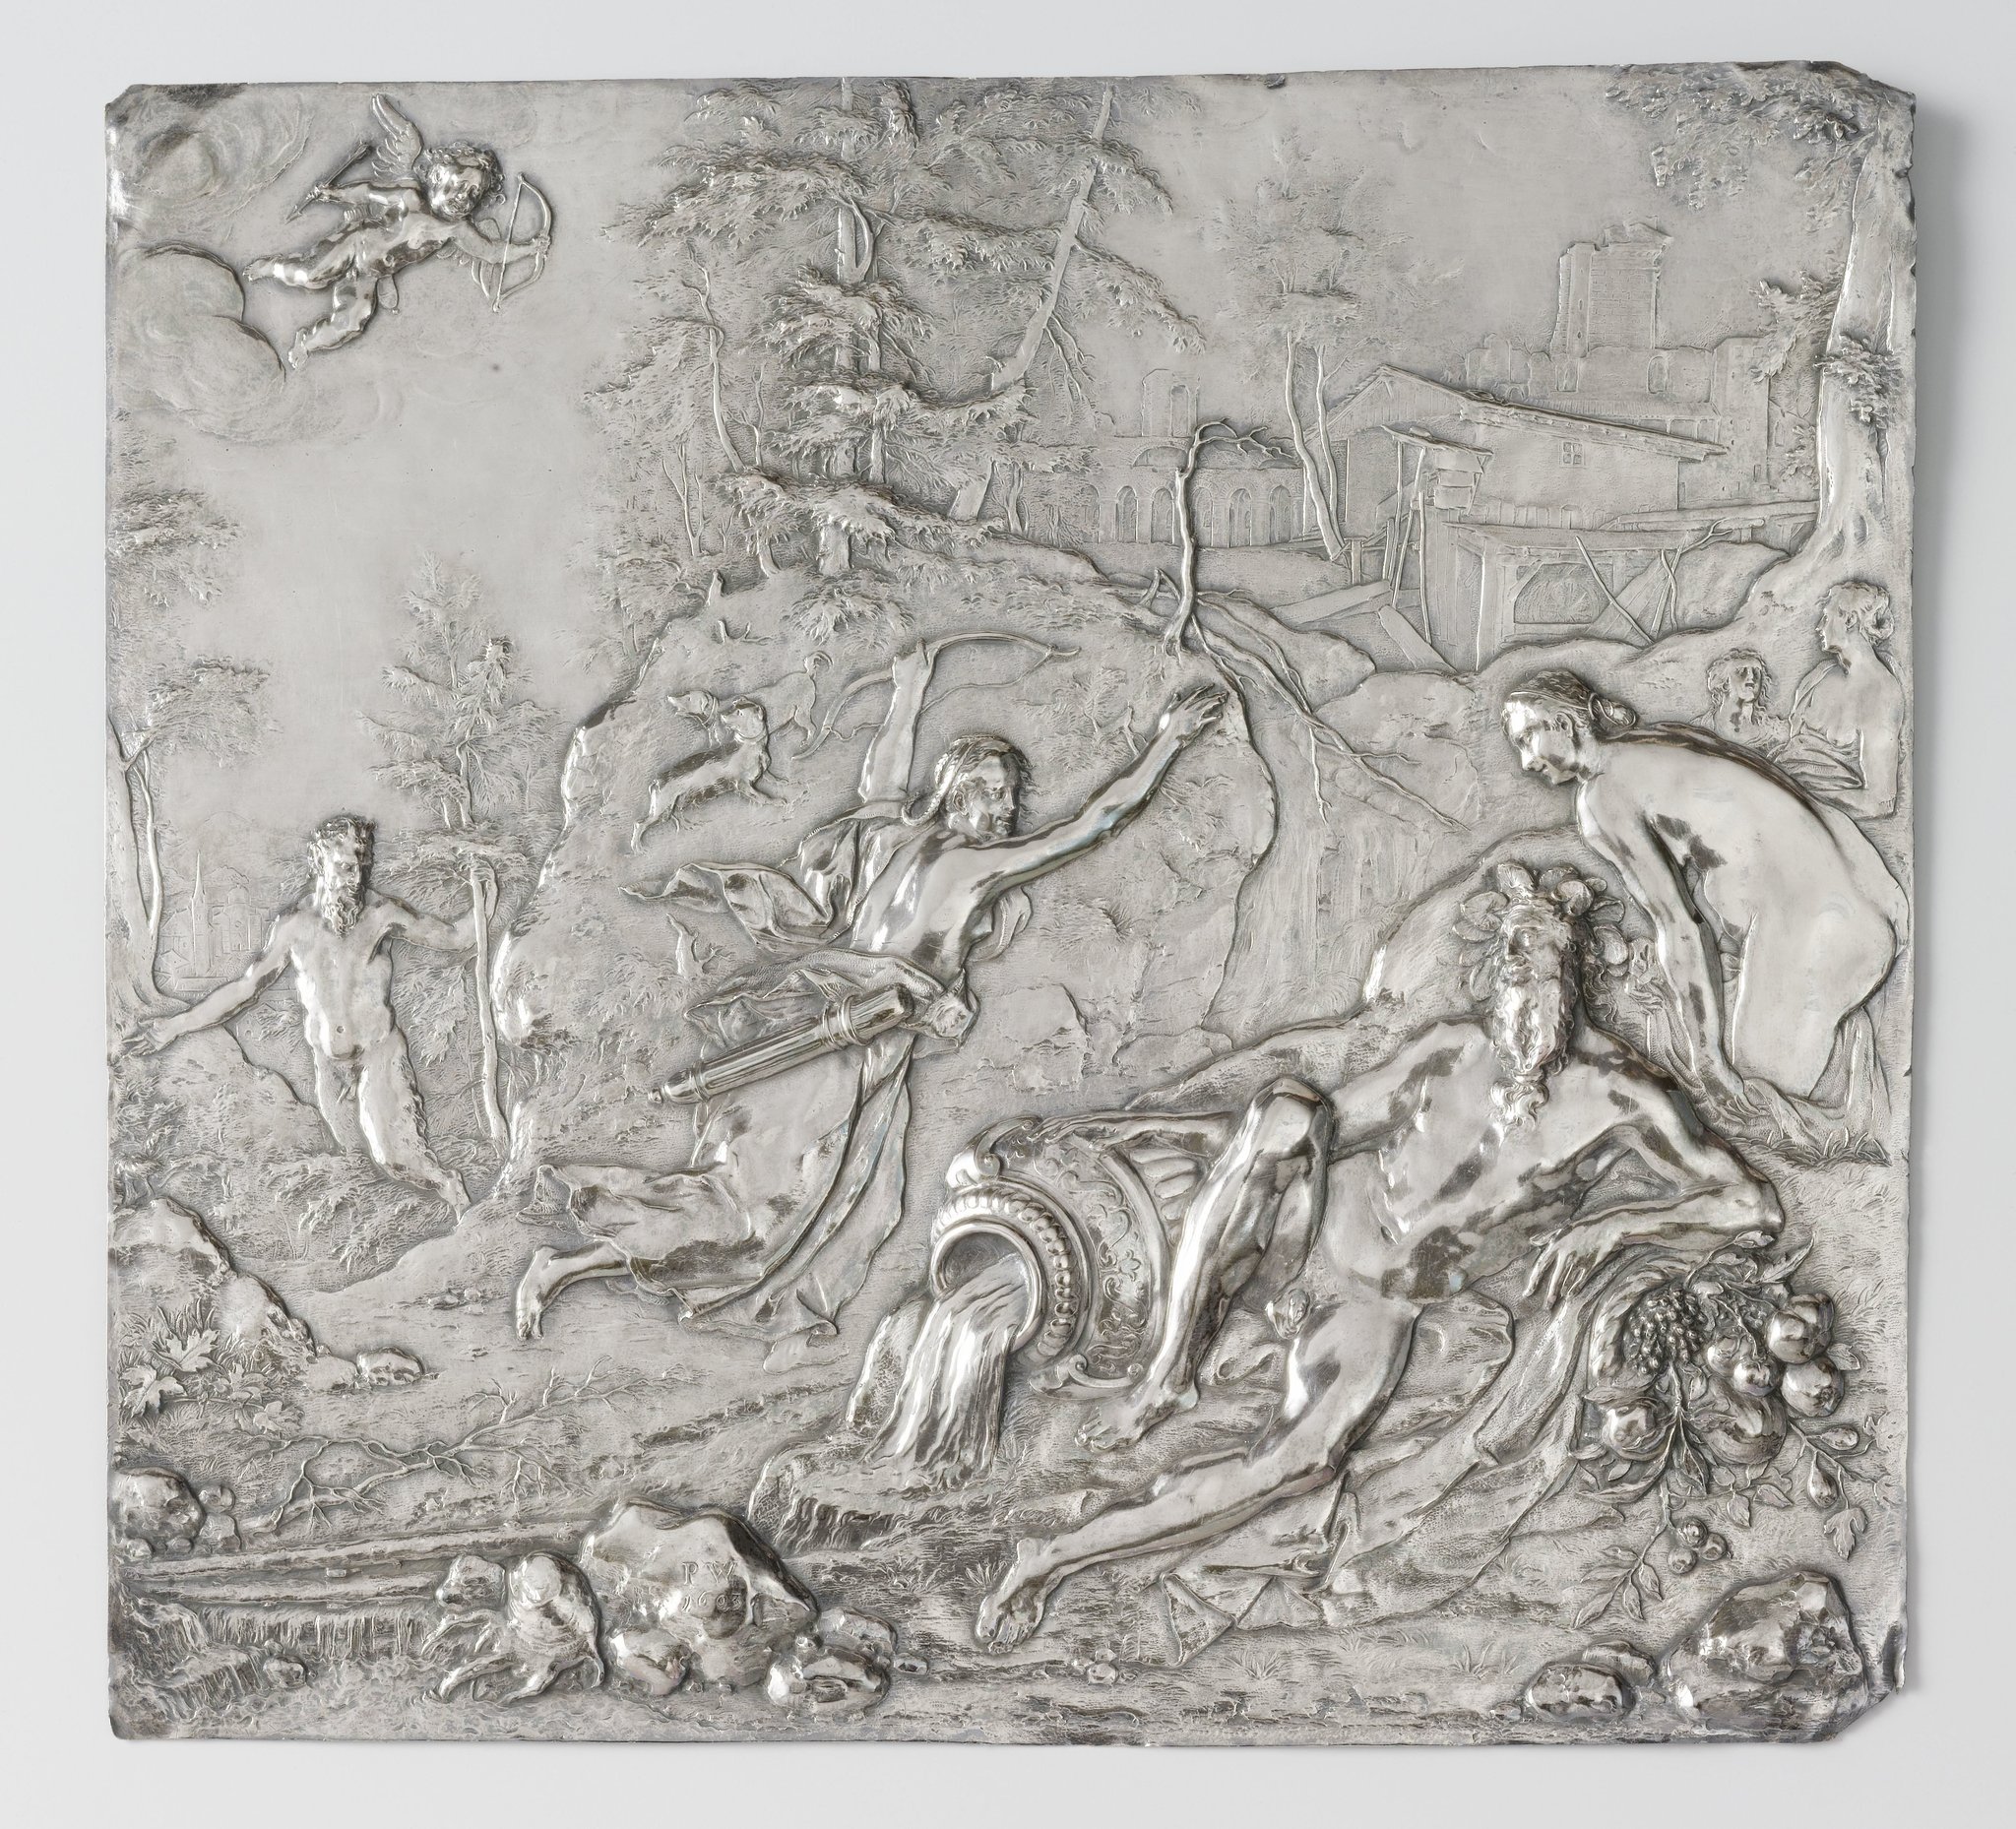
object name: plaque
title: Pan and Syrinx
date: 1603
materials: silver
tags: syrinx changed into a reed: while fleeing from pan, the nymph syrinx is changed into reed by her sisters, the naiads (ovid, metamorphoses i 705)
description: Een rechthoekige zilveren plaquette met de voorstelling van Pan en Syrinx, voor de metamorphose. Gemerkt.